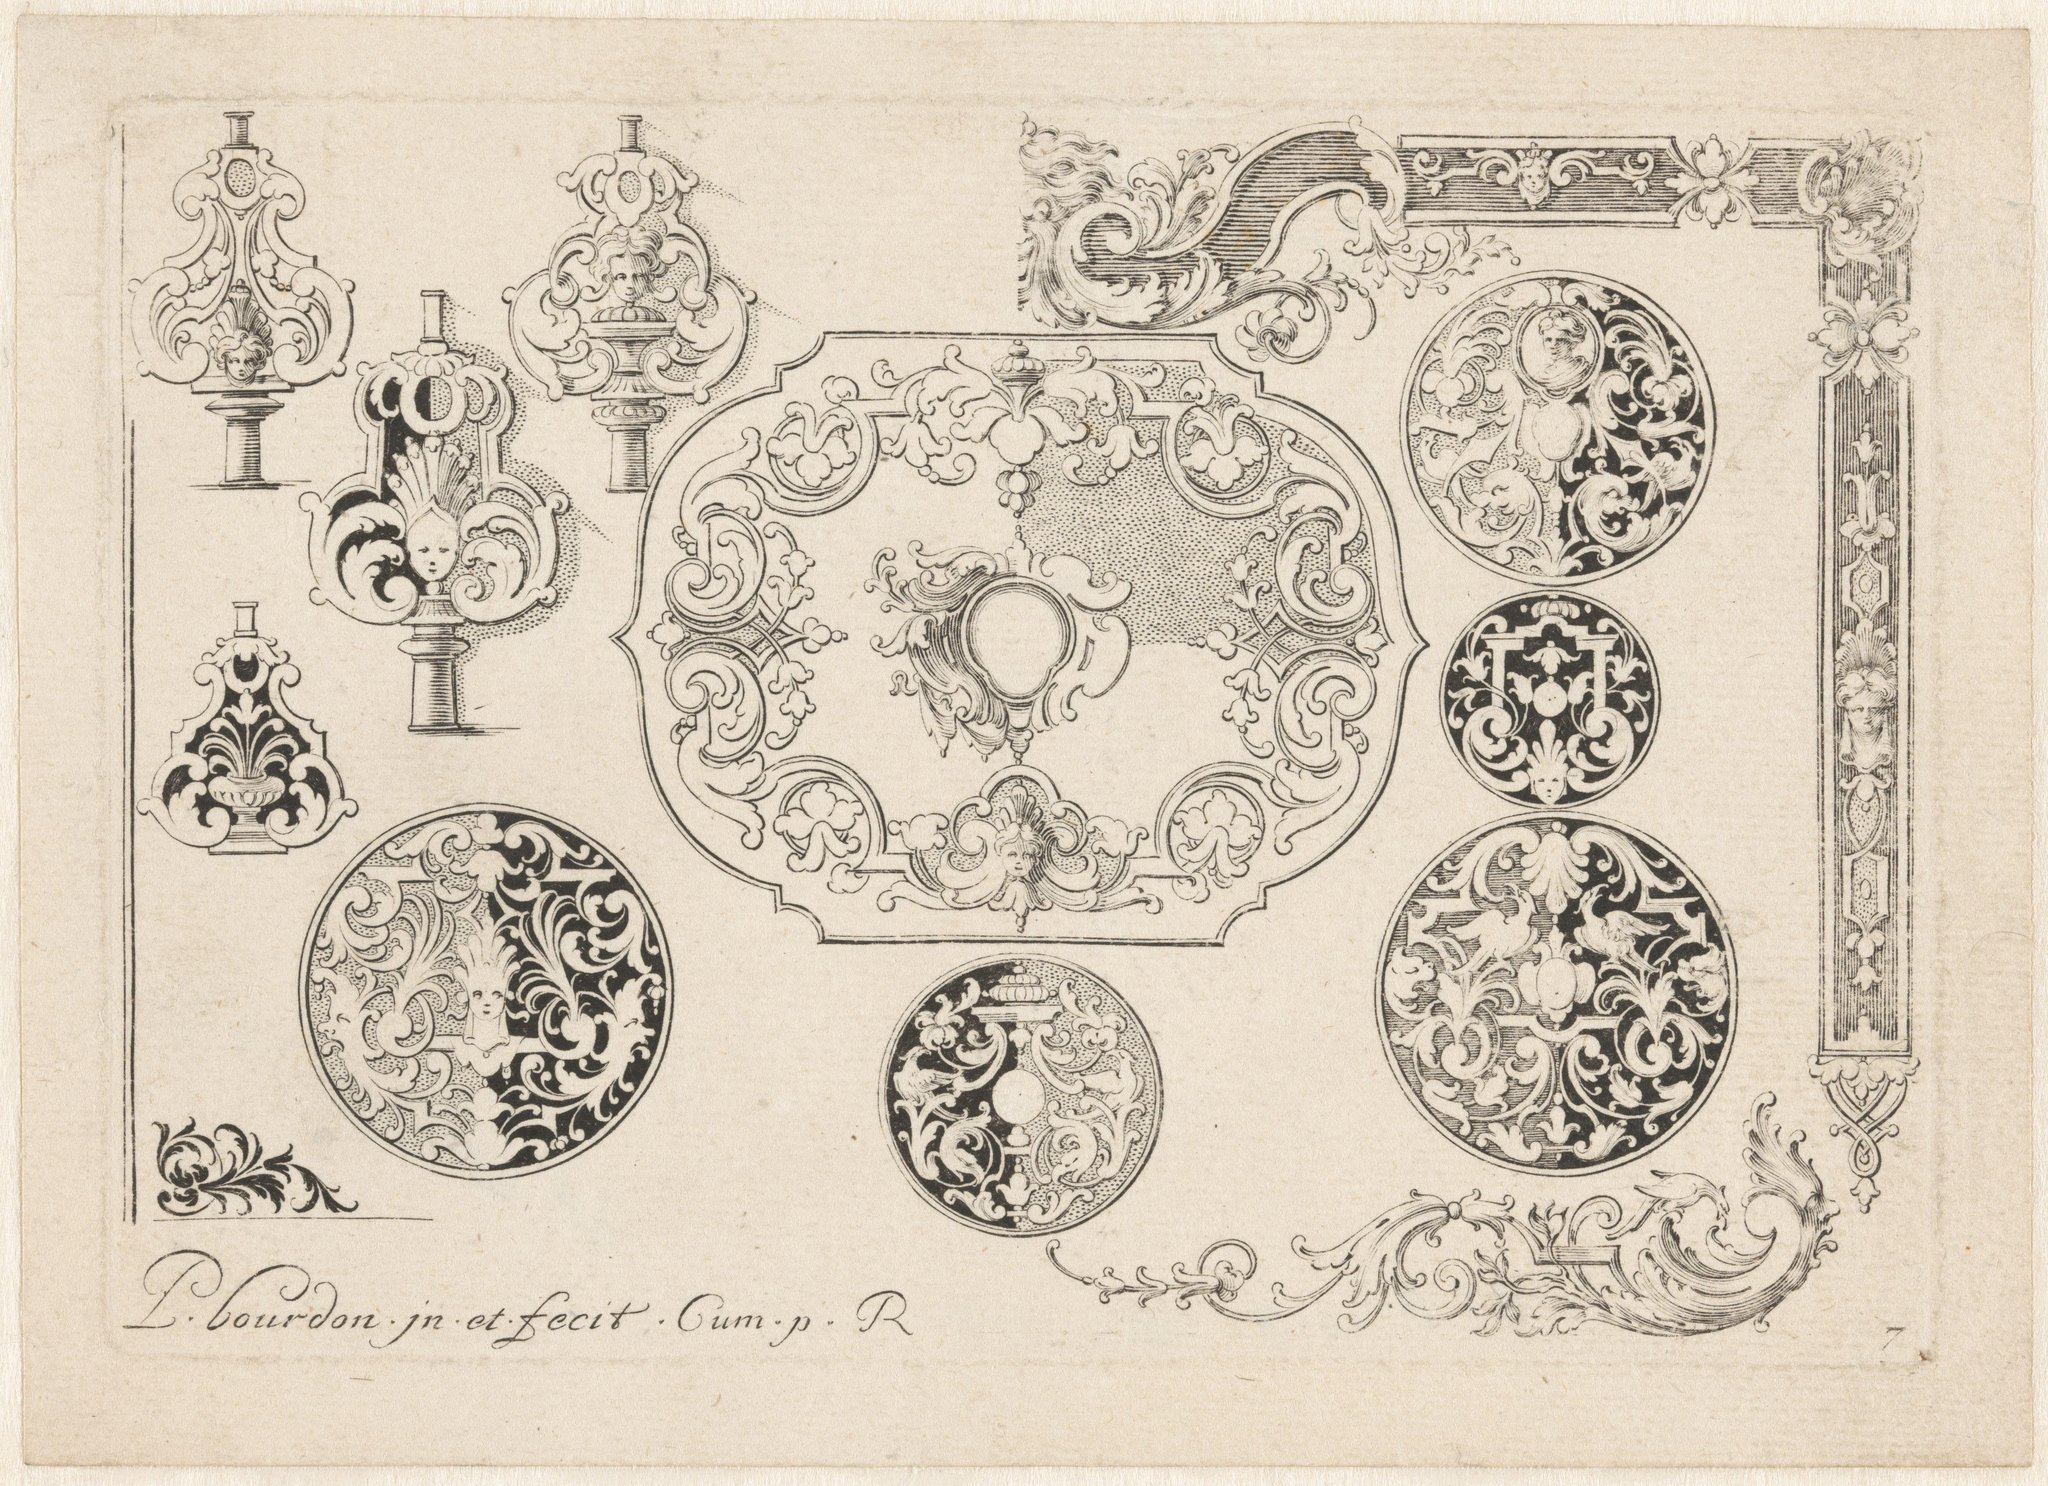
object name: print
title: Livre Premier: Essais de gravure par Pierre Bourdon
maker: pierre bourdon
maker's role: print maker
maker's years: 1656-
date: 1703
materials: paper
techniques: engraving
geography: paris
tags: ornaments ~ art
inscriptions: collector's mark: Lugt 2760, signature: ‘P. bourdon in et fecit’, number: ‘7’, collector's mark: Lugt 2228, privilege: ‘Cum. p. R’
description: Blad uit serie van zeven van ontwerpen voor horlogemakers, goudsmeden, beeldhouwers en graveurs.